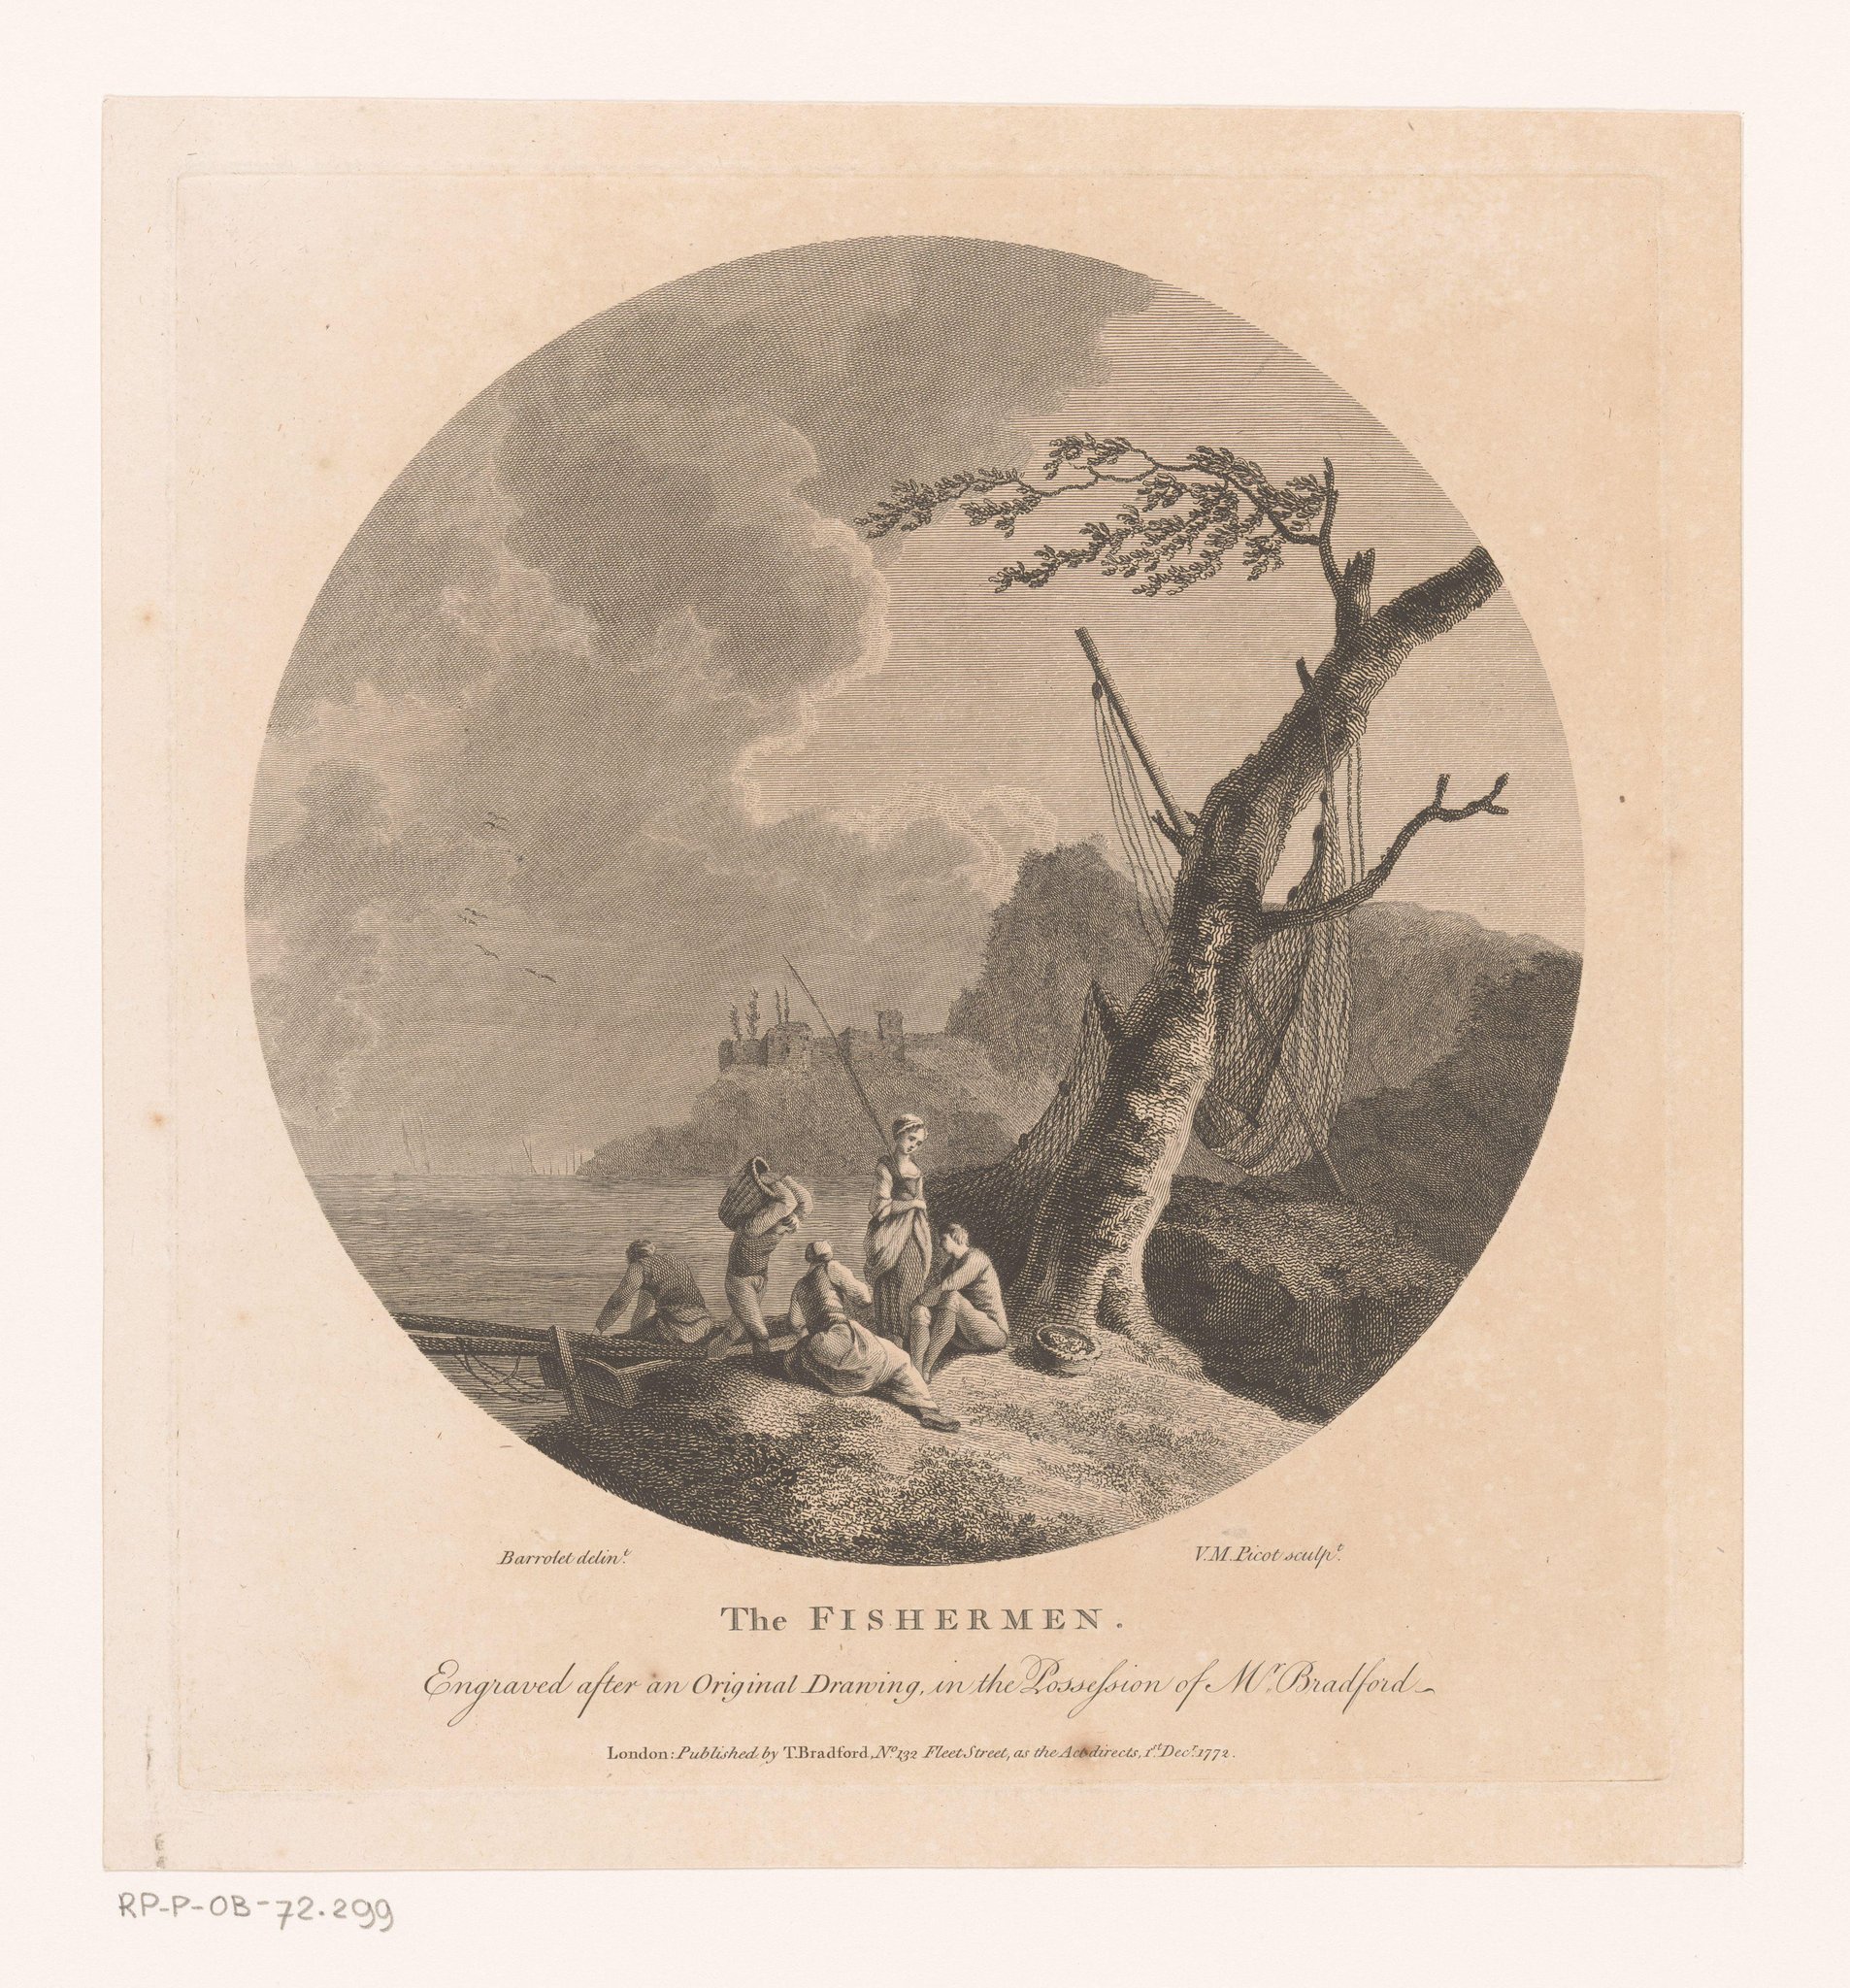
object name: print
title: Landschap met vissers bij een boom met visnetten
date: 1772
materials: paper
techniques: engraving, etching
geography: london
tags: landscapes with waters, waterscapes, seascapes (in the temperate zone), fisherman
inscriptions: collector's mark: Lugt 2228